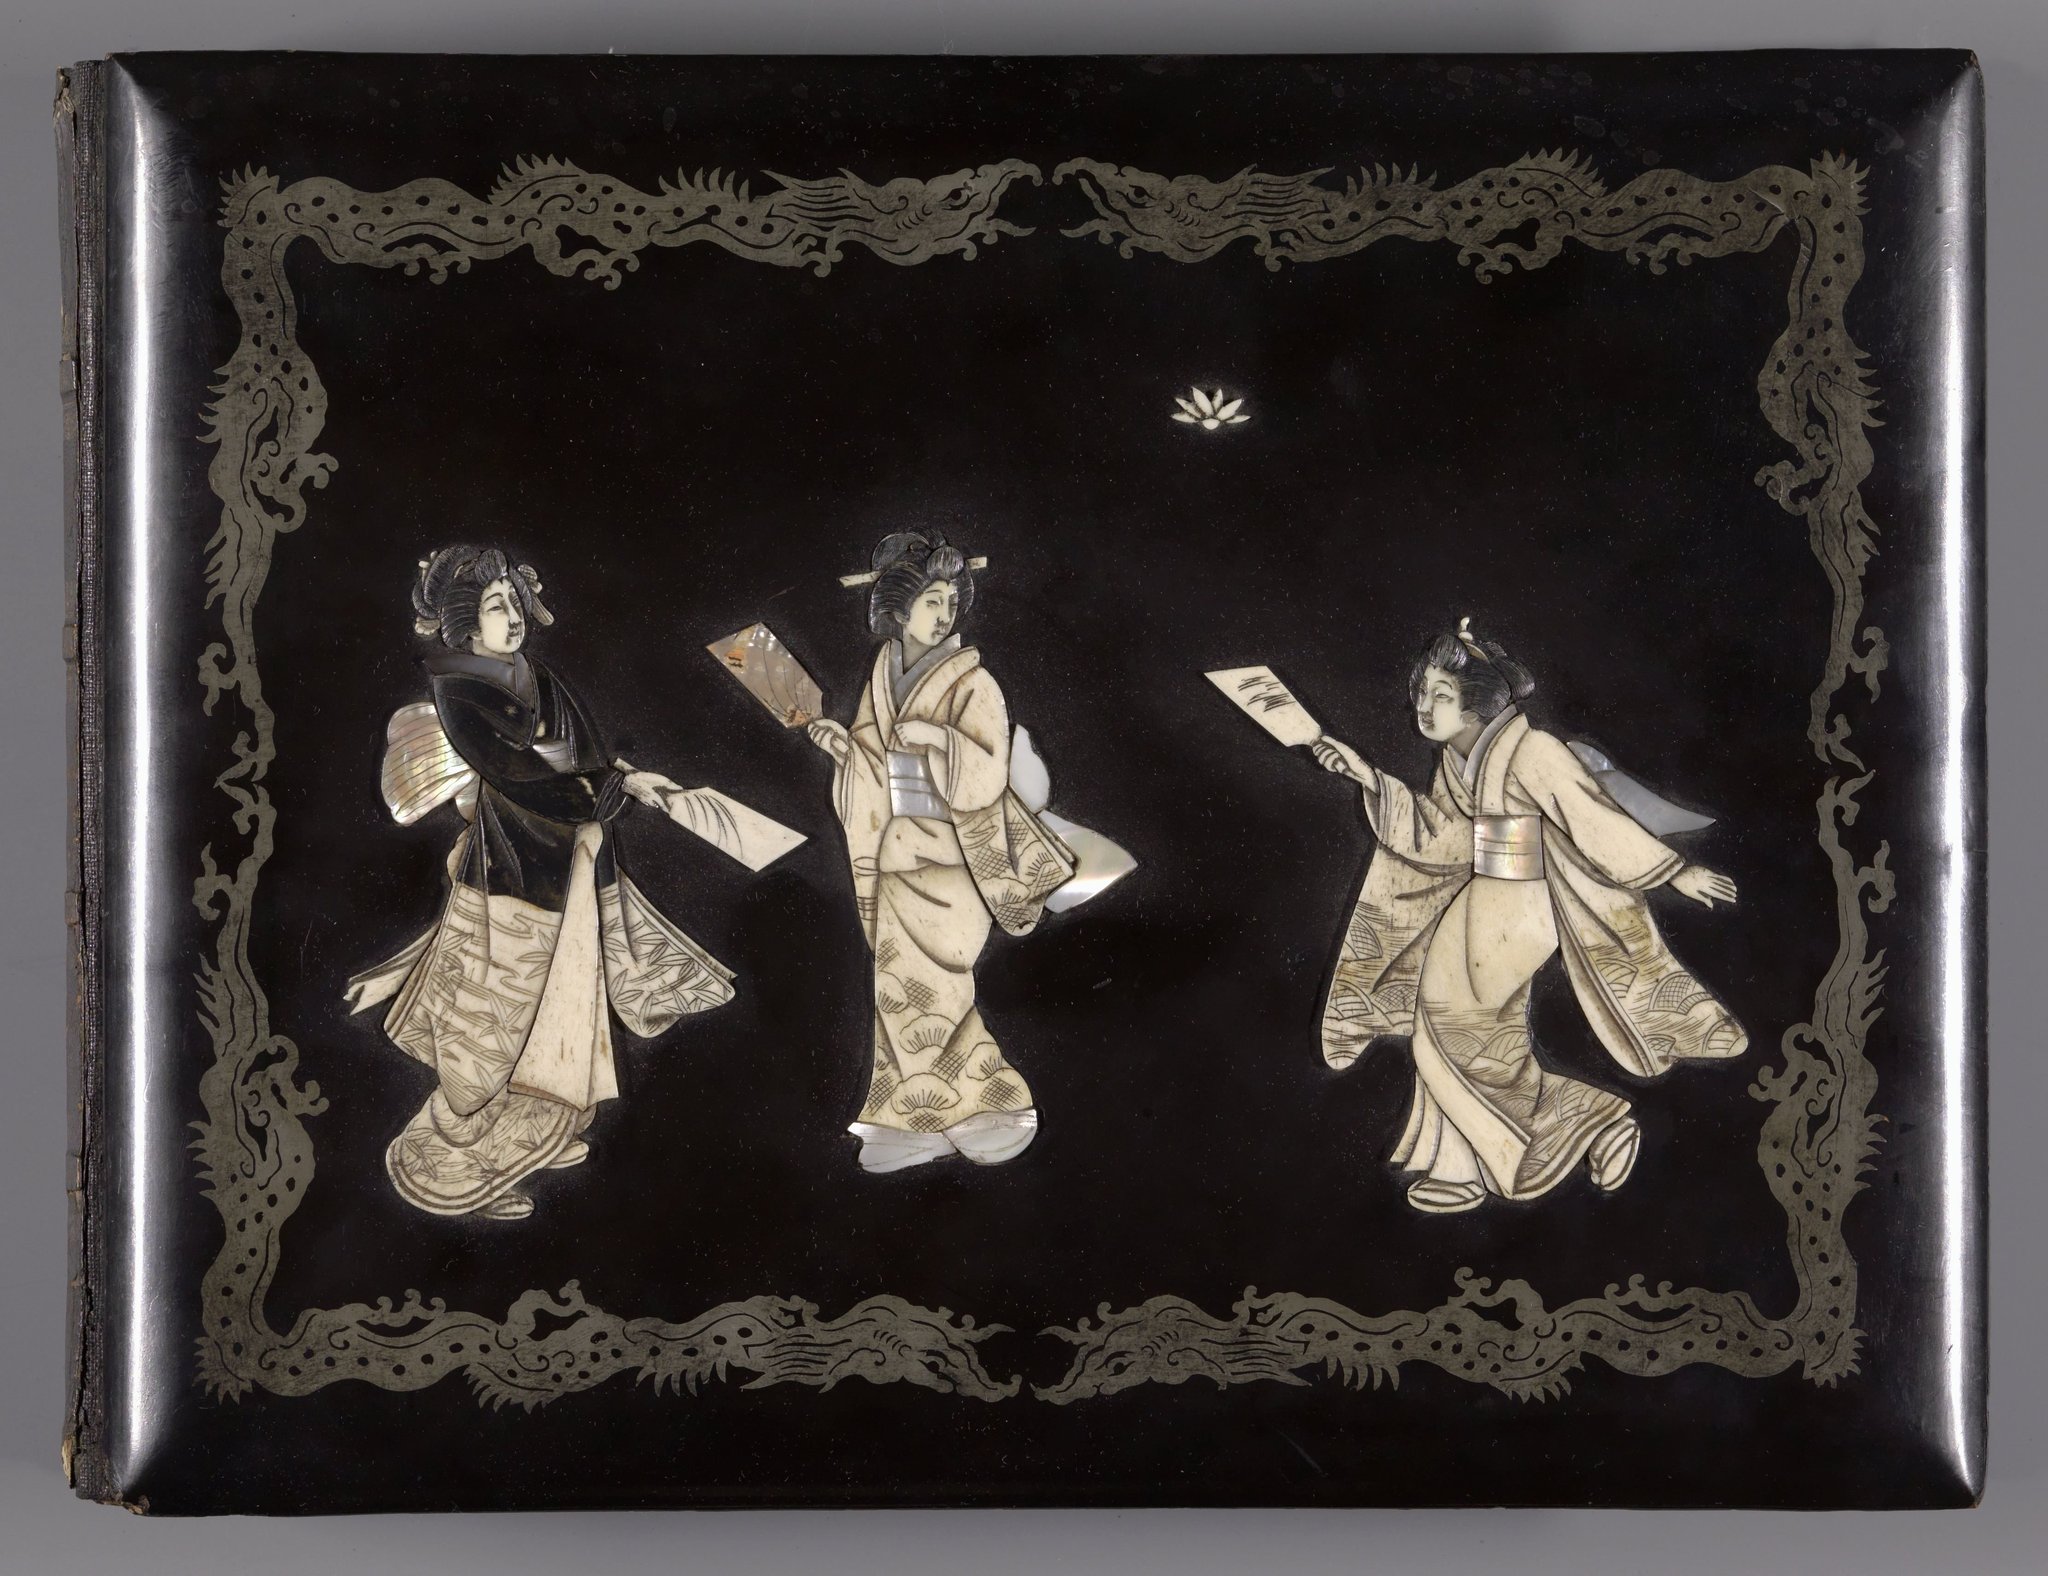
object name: photograph album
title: Fotoalbum (leeg)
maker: Anonymous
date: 1860-1900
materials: cardboard, paint, ivory, lacquer, leather, mother of pearl, paper, silk, textile, watercolor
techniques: bookbinding, brush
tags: adult woman, book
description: Fotoalbum in leren band met twee lakpanelen. Op het voorpaneel drie Japanse vrouwfiguren, van ivoor en parelmoer; het achterpaneel toont een haan bij een put met kuikens, (vermoedelijk) van ingelegd parelmoer. Het album bevat negen kartonnen bladen overtrokken met zijde. Elke pagina heeft uitsparingen voor twee kabinetfoto's. Daaromheen zijn geschilderde versieringen aangebracht: bloemen, vogels, bloeiende bomen, huizen en landschappen.